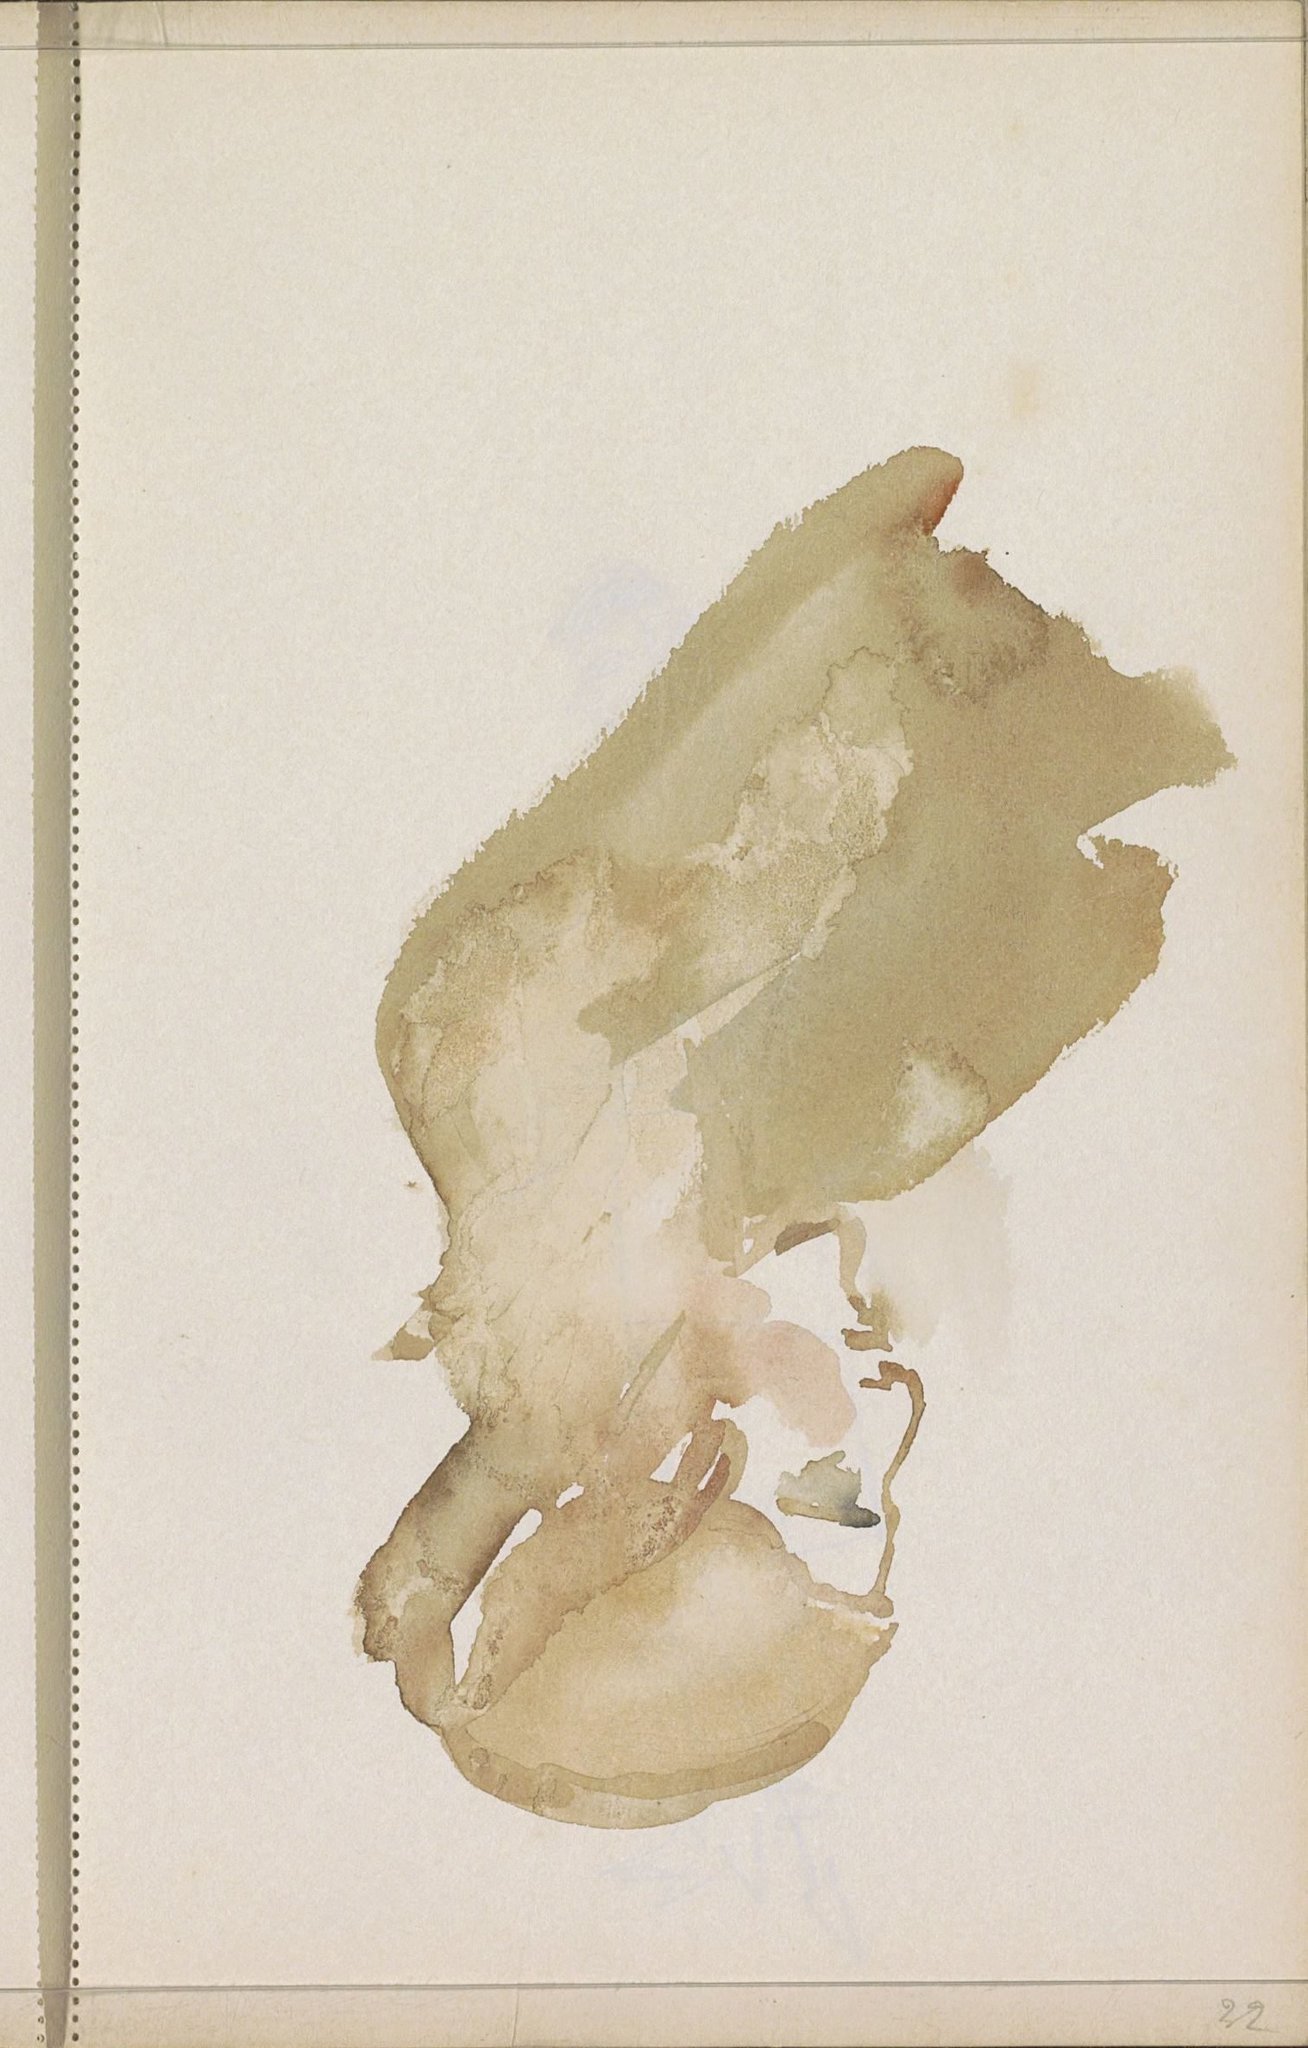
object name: sketchbook leaf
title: Vrouw, in profiel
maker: isaac israels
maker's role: draughtsman, painter, print maker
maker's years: 1865-1934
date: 1875-1934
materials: paper, watercolor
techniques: brush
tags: adult woman (+ sideview, profile)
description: Blad 22 recto uit schetsboek LII met 43 bladen.